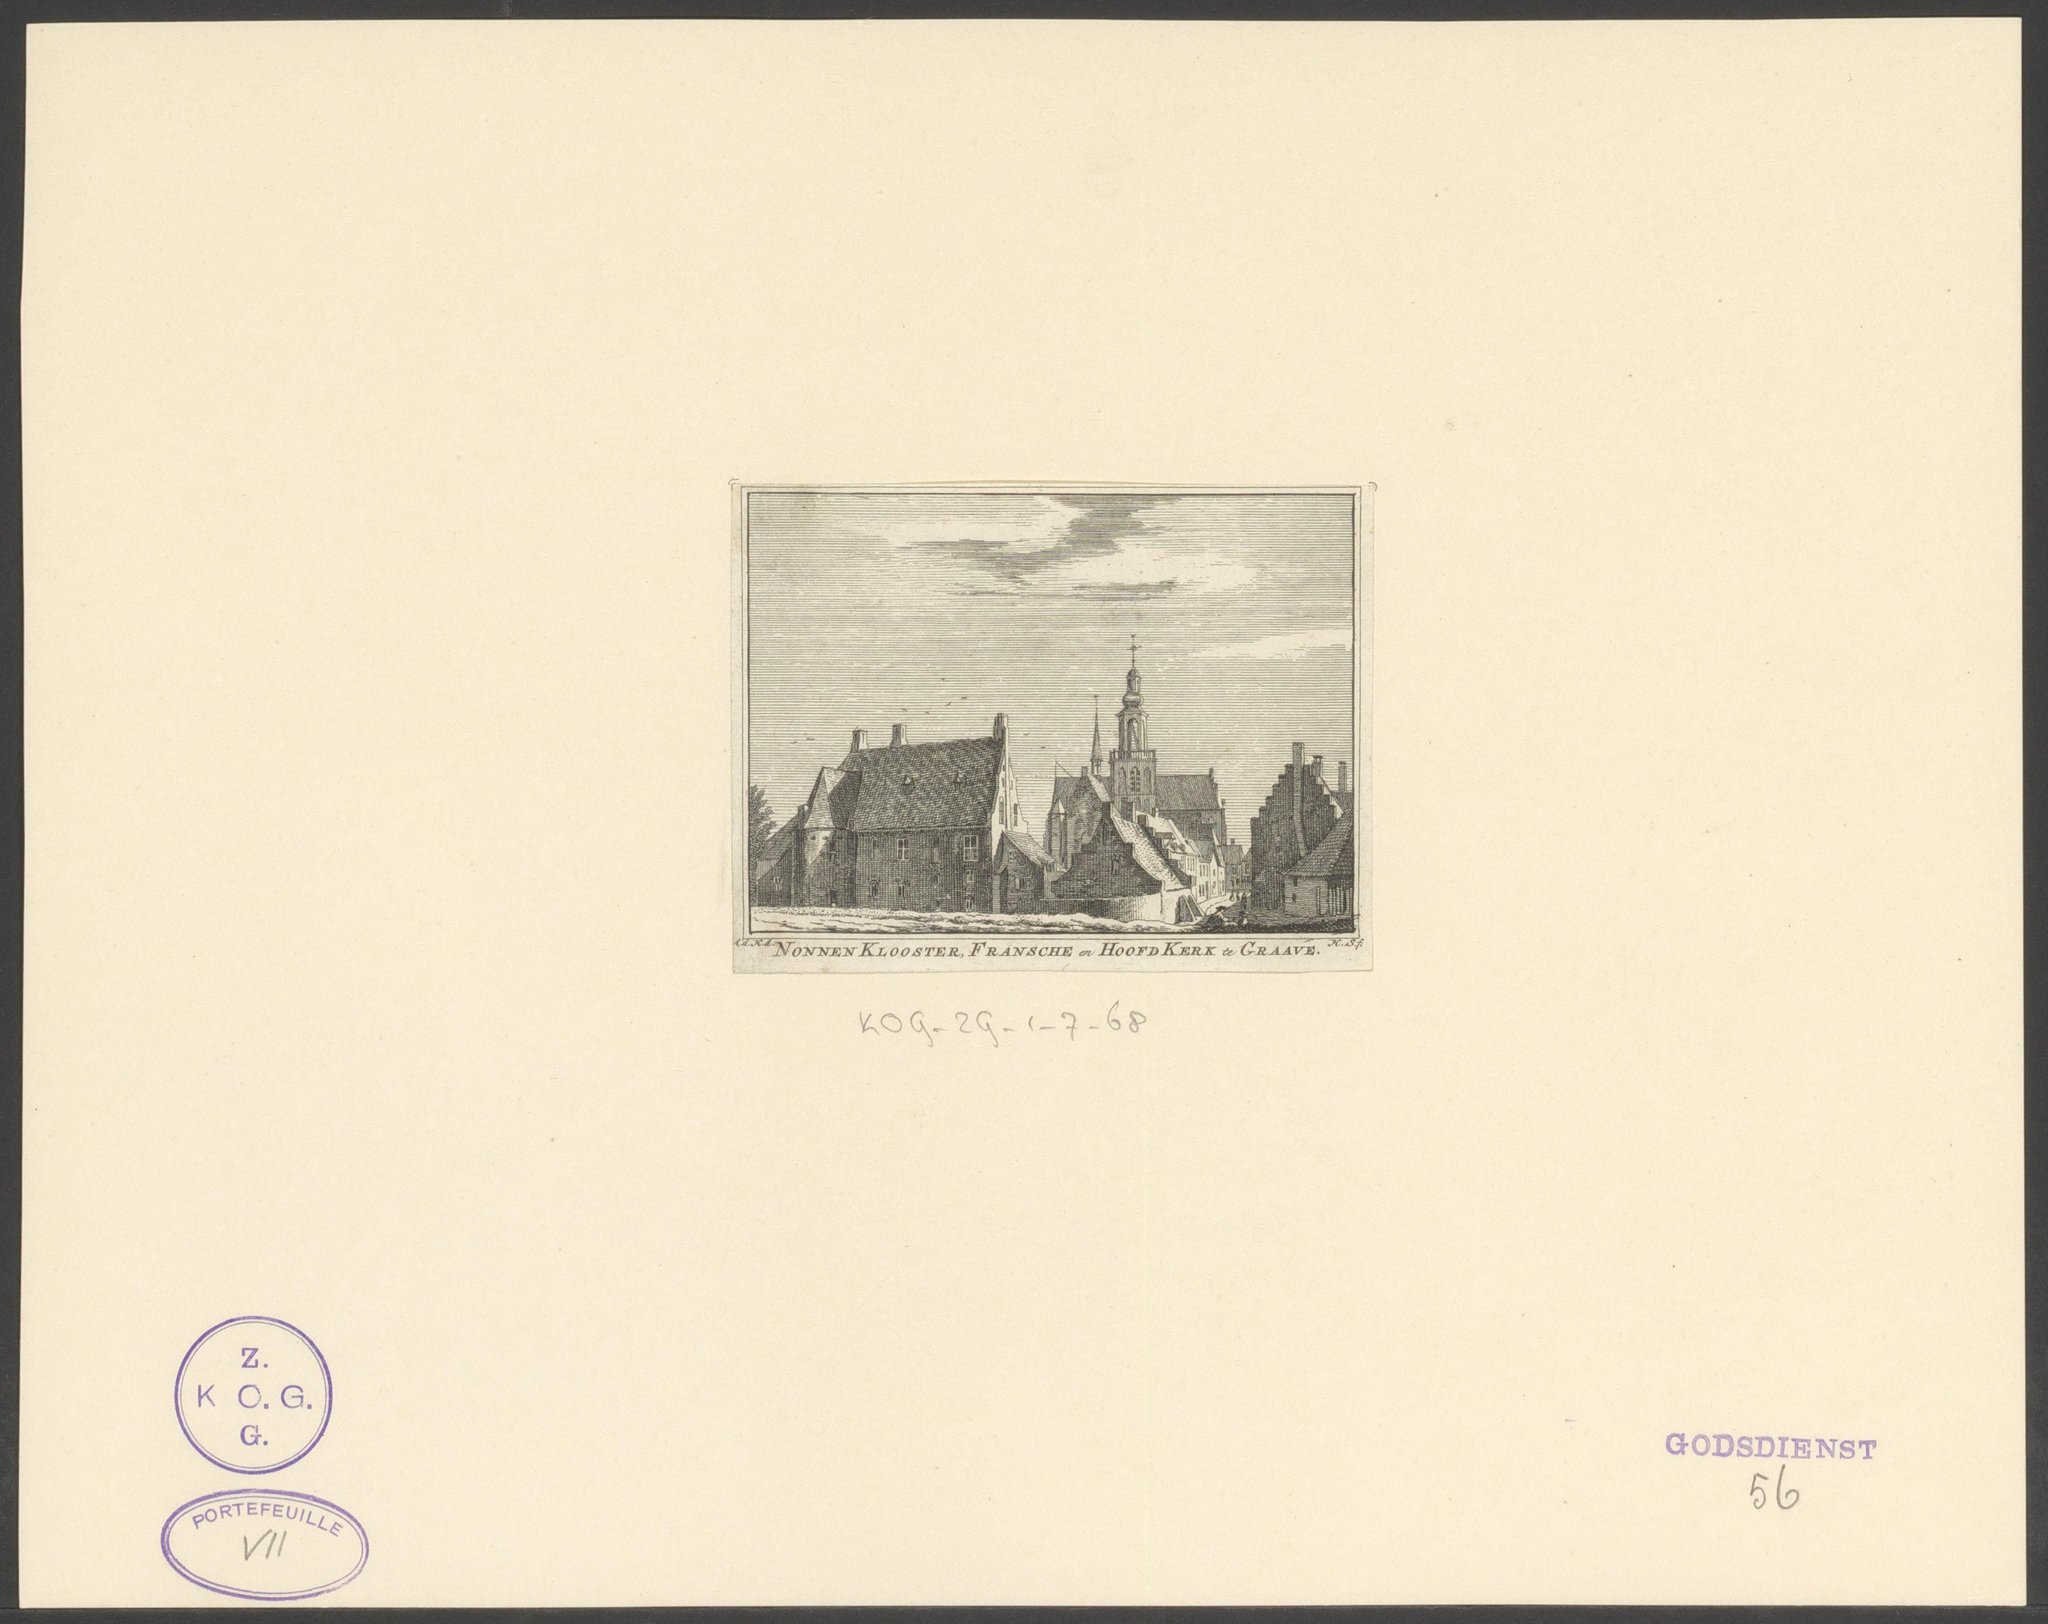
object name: print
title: Gezicht op het nonnenklooster, de Sint-Elisabethkerk en de Protestantse kerk te Grave, 1732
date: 1744-1792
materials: paper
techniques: engraving, etching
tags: cloisters ~ monastery, grave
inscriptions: stamp, stamp, collector's mark: Lugt 1641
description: Prent waarschijnlijk uit: Het Verheerlykt Nederland of kabinet van hedendaagsche gezigten (...). Amsterdam: Isaak Tirion, 1746, dl. 2. Of uit: Nederlandsche tafereelen; of eene keurige verzameling van negen honderd fraaije gezigten van steden, dorpen, sloten, oudheden (…). 9 dln. Amsterdam: Jan de Groot, 1792, dl. 2, ill. 141-142.